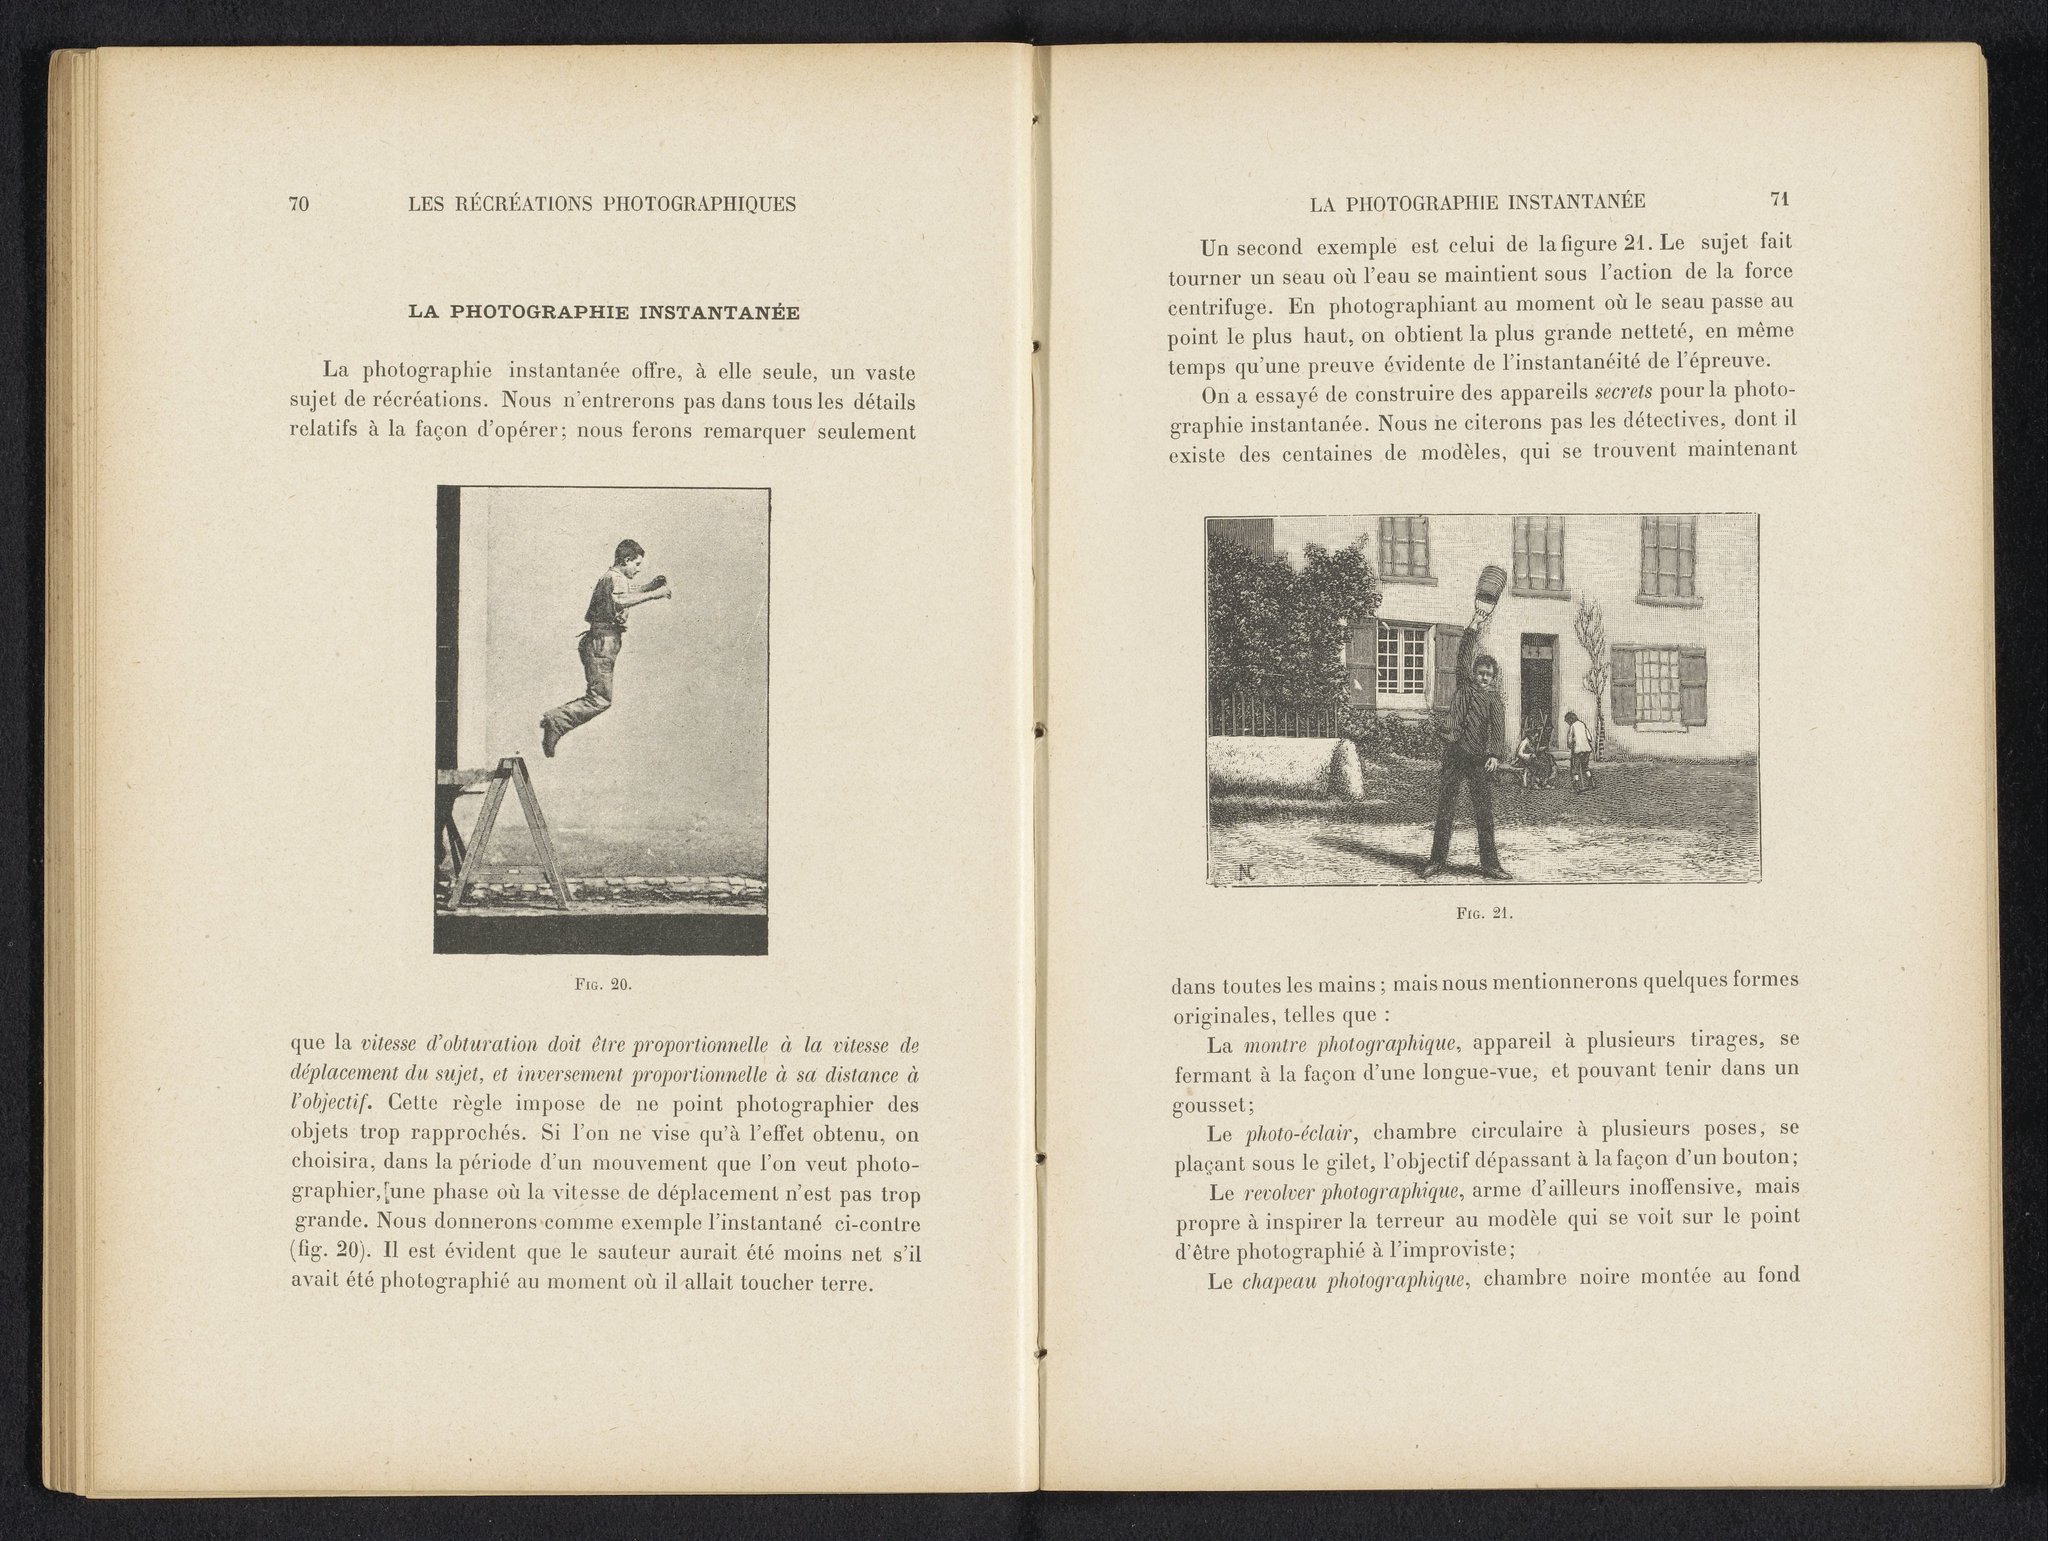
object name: page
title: Man die van een trap springt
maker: Anonymous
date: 1883-1893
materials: paper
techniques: autotype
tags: jumping down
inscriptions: number: ‘Fig. 20.’